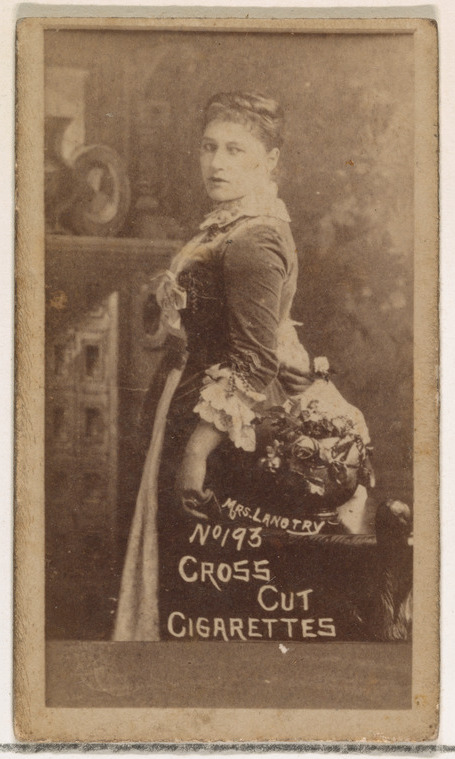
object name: print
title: Card Number 193, Mrs. Langtry, from the Actors and Actresses series (N145-1) issued by Duke Sons & Co. to promote Cross Cut Cigarettes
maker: w. duke, sons & co.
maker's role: publisher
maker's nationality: american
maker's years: 1870-1920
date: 1880-1889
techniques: albumen silver print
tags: portraits,women,actresses